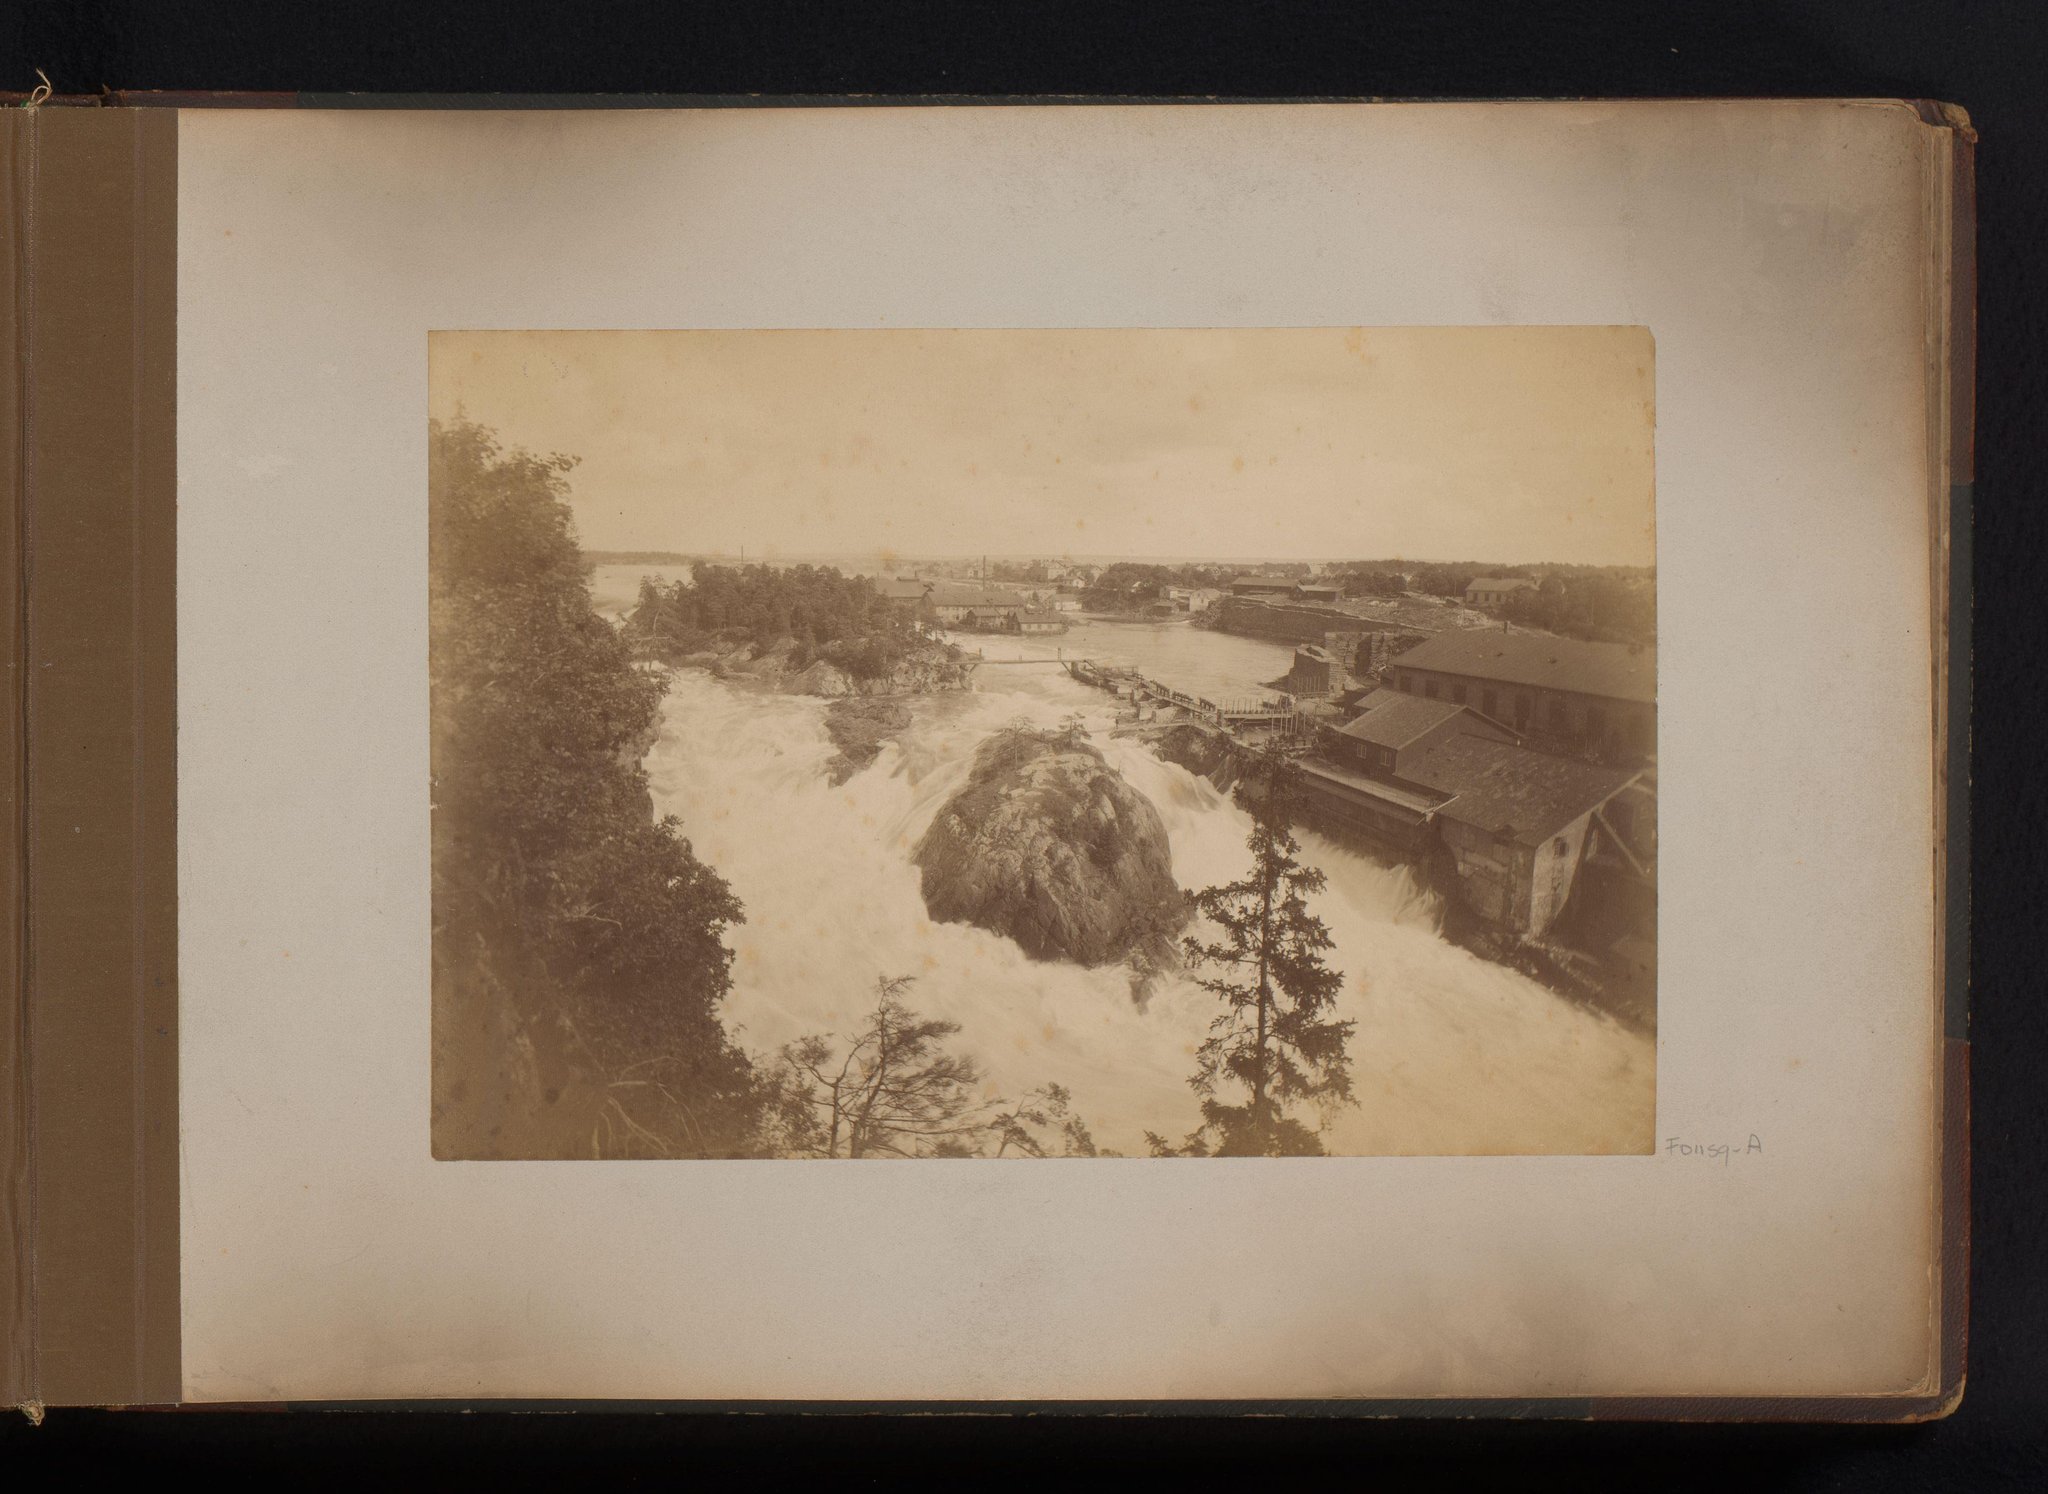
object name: photograph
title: Gezicht op fabrieken langs een waterval in Scandinavië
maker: Anonymous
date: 1880-1900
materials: photographic support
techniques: albumen print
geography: scandinavia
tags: waterfall, industries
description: Onderdeel van Reisalbum met opnames van bezienswaardigheden in Zweden, Noorwegen, Denemarken, Beieren, Milaan en Parijs.